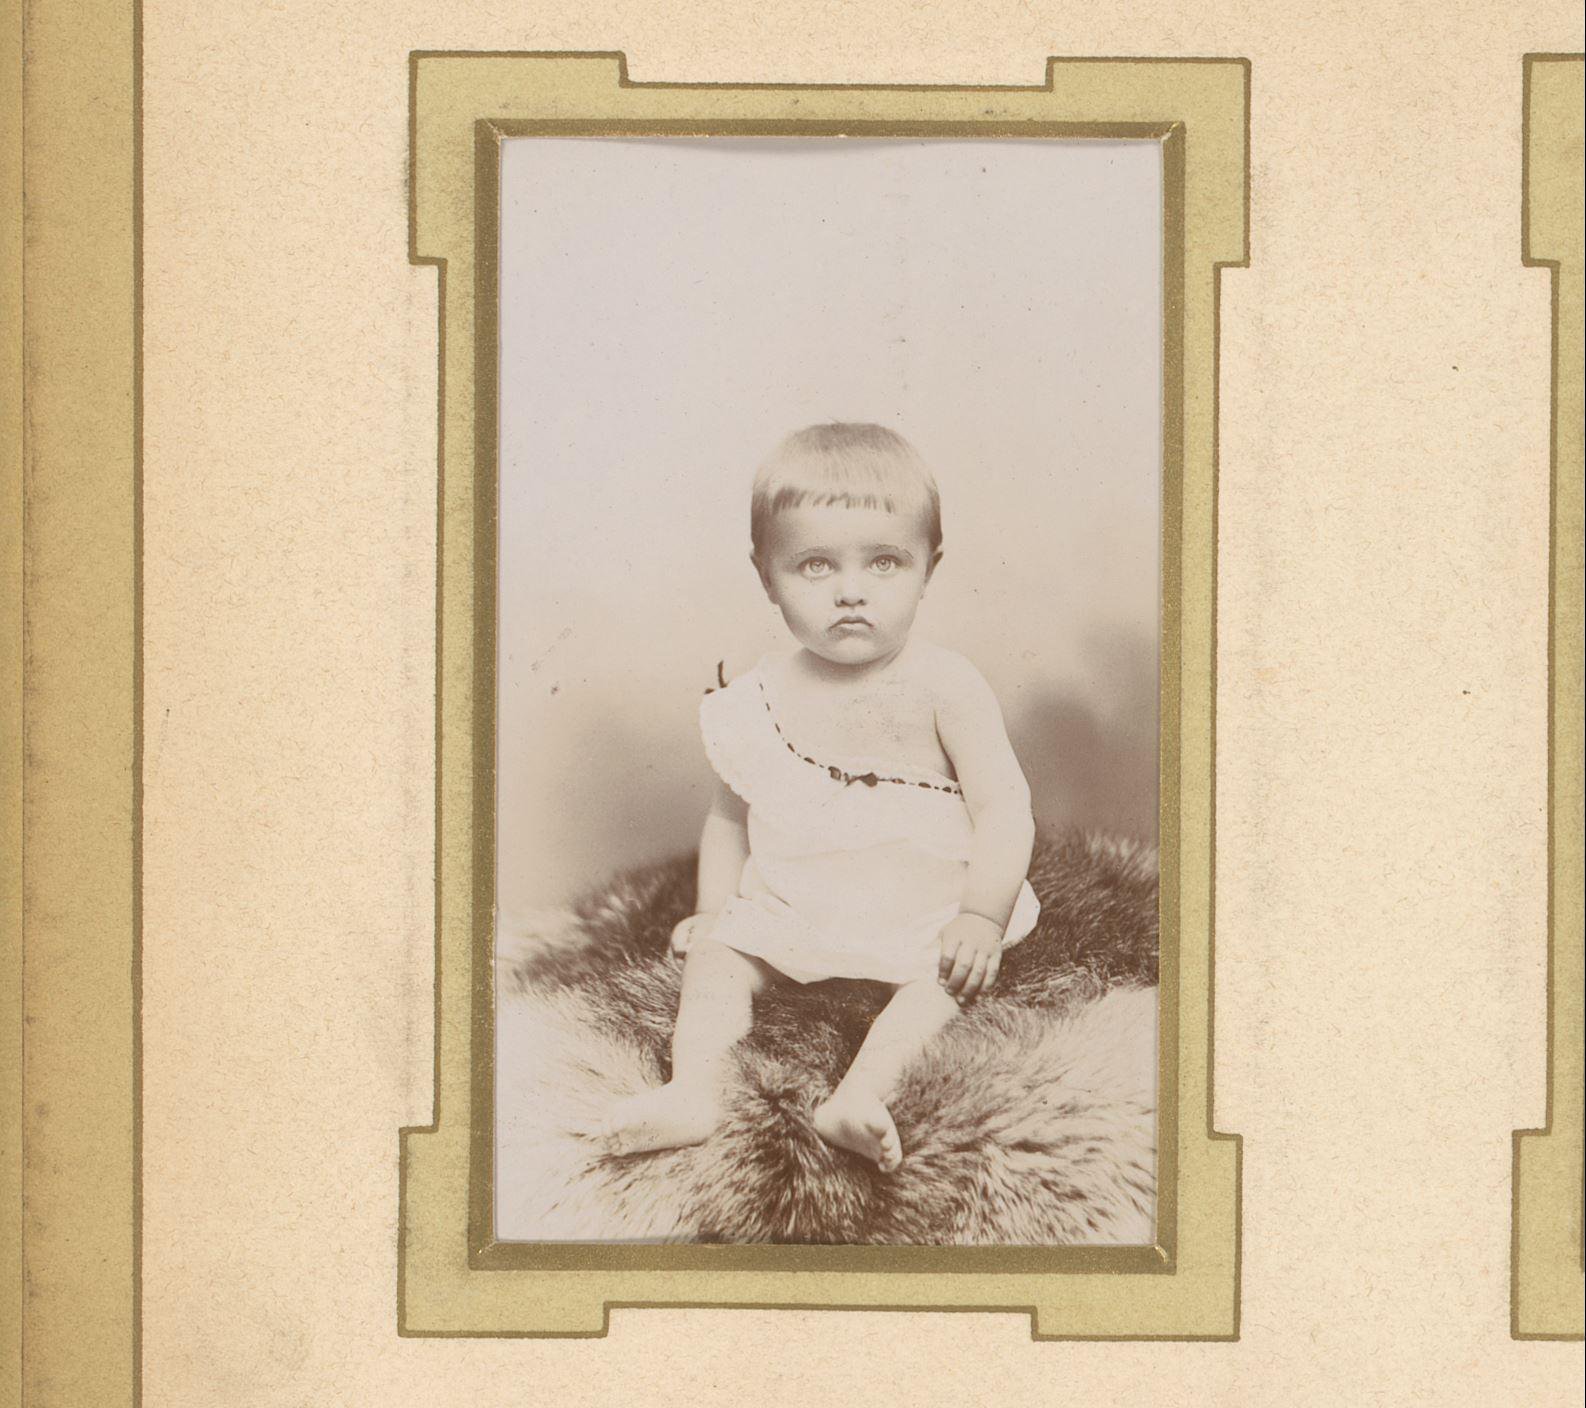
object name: album leaf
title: Portret van Roger van Hoecke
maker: léonard tronchet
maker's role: fotograaf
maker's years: 1855-1925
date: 1880-1920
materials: cardboard, photographic support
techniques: gelatin silver print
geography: leuven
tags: boy (child between toddler and youth)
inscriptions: inscription: ‘Photogrpahie/ L. Tronchet/ Lyon/ 6, Rue Servient’, annotation: ‘Roger van Hoecke/ 9 mois’